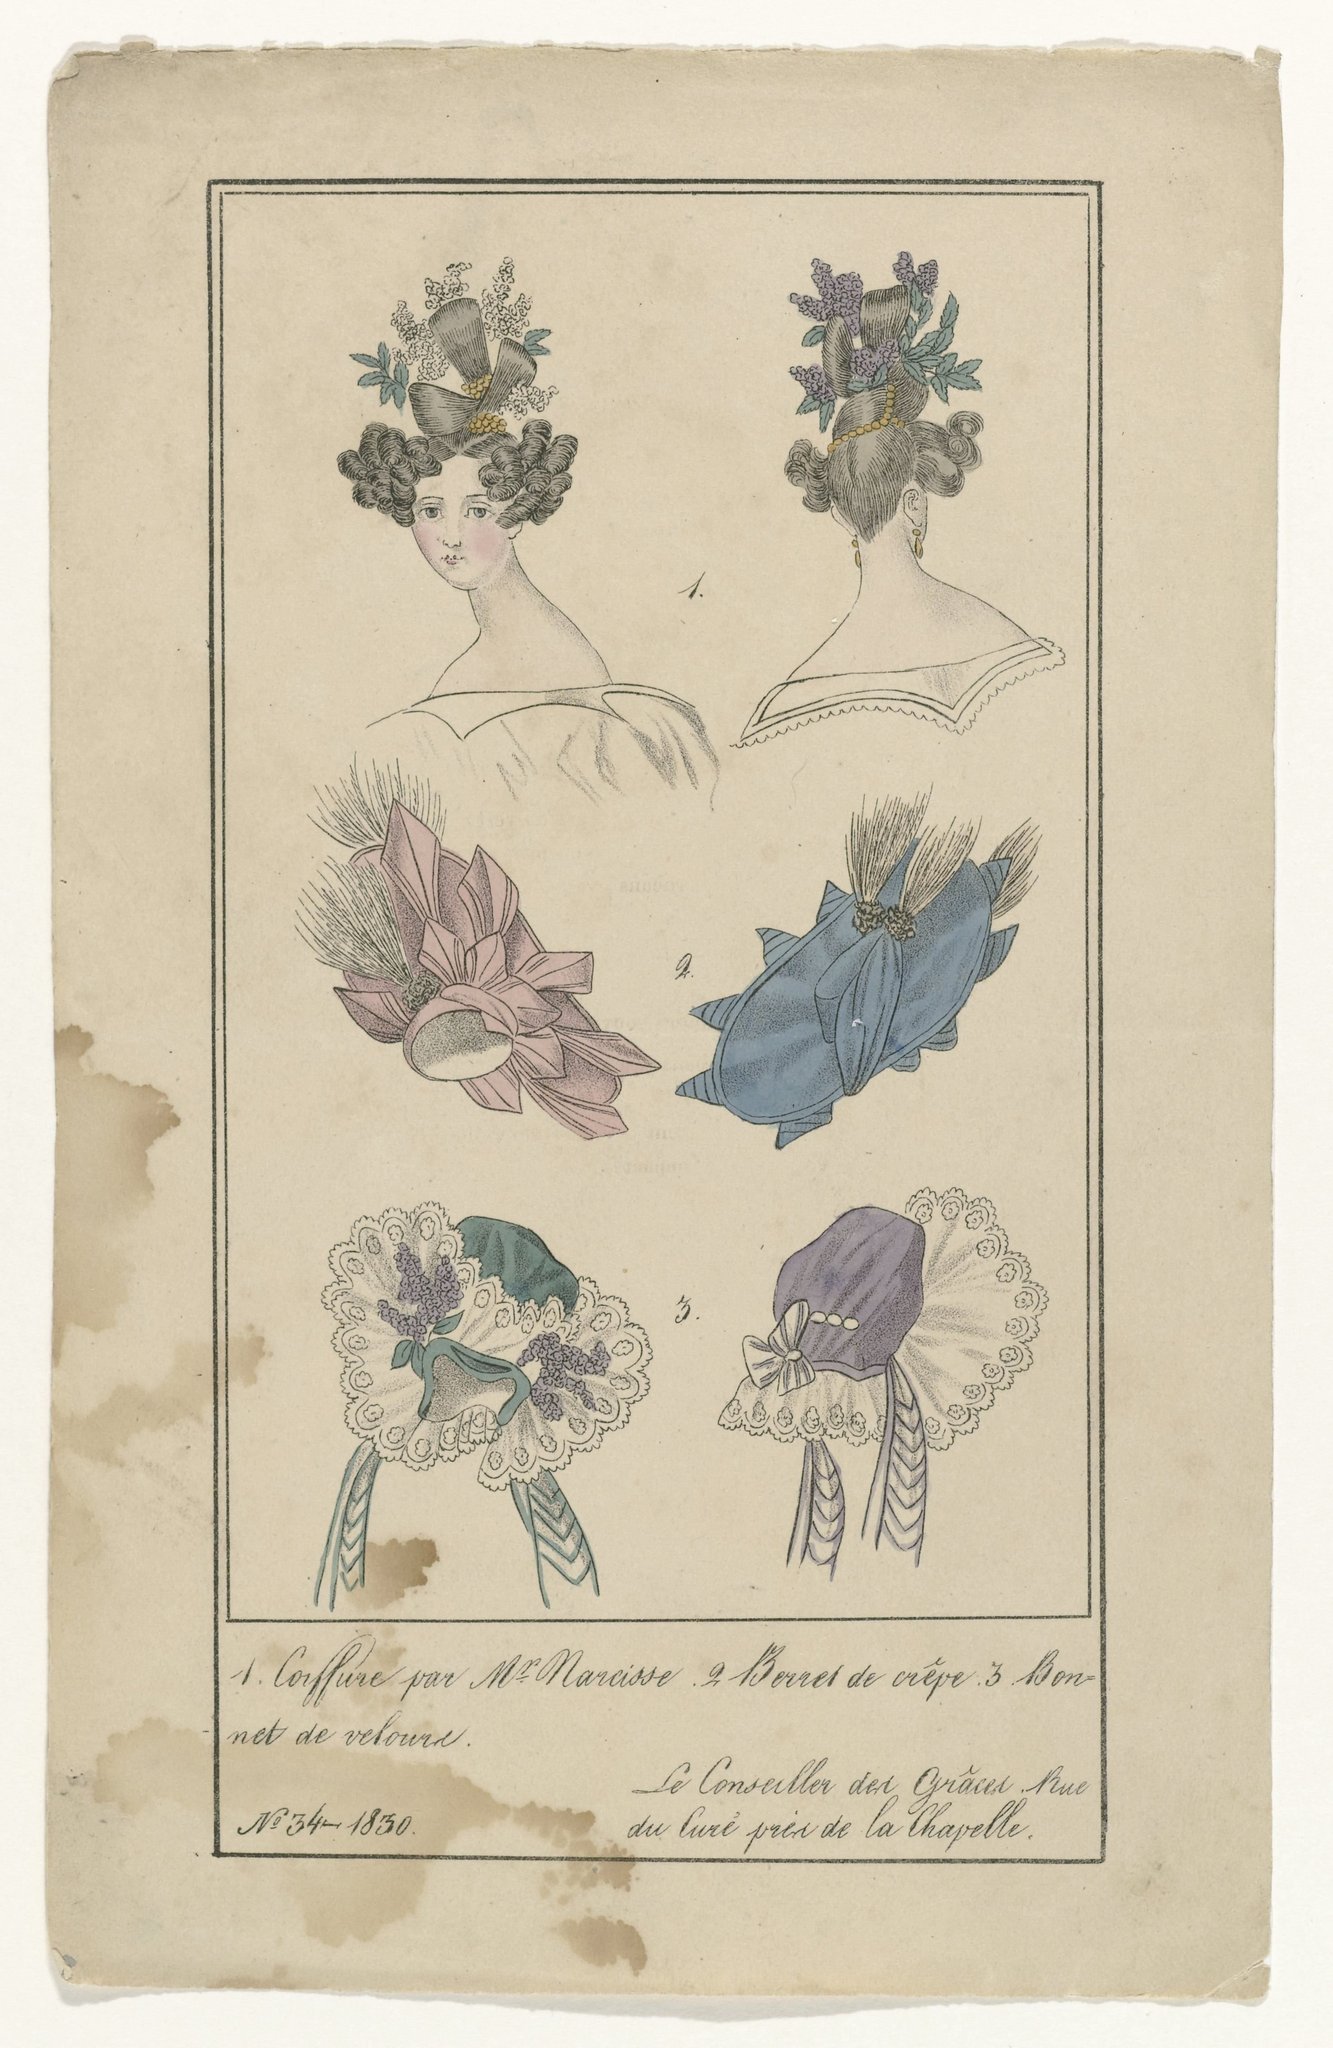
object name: fashion print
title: Le Conseiller des Grâces, 1830, No. 34: 1. Coiffure par Mr Narciss (...)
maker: Anonymous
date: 1830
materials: paper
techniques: hand coloring, lithograph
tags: head-gear: beret (+ women's clothes), styles of hairdress - aa - ~ women, head-gear: cap (+ women's clothes), fashion plates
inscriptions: title: ‘Le Conseiller des Grâces Rue du Curé prés de la Chapelle.’, caption: ‘1. Coiffure par Mr Narcisse. 2 Berret de crêpe. 3 Bonnet de velours.’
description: 1. Coiffure door Mr Narcisse. 2. Baret van crêpe. 3. Muts van fluweel.